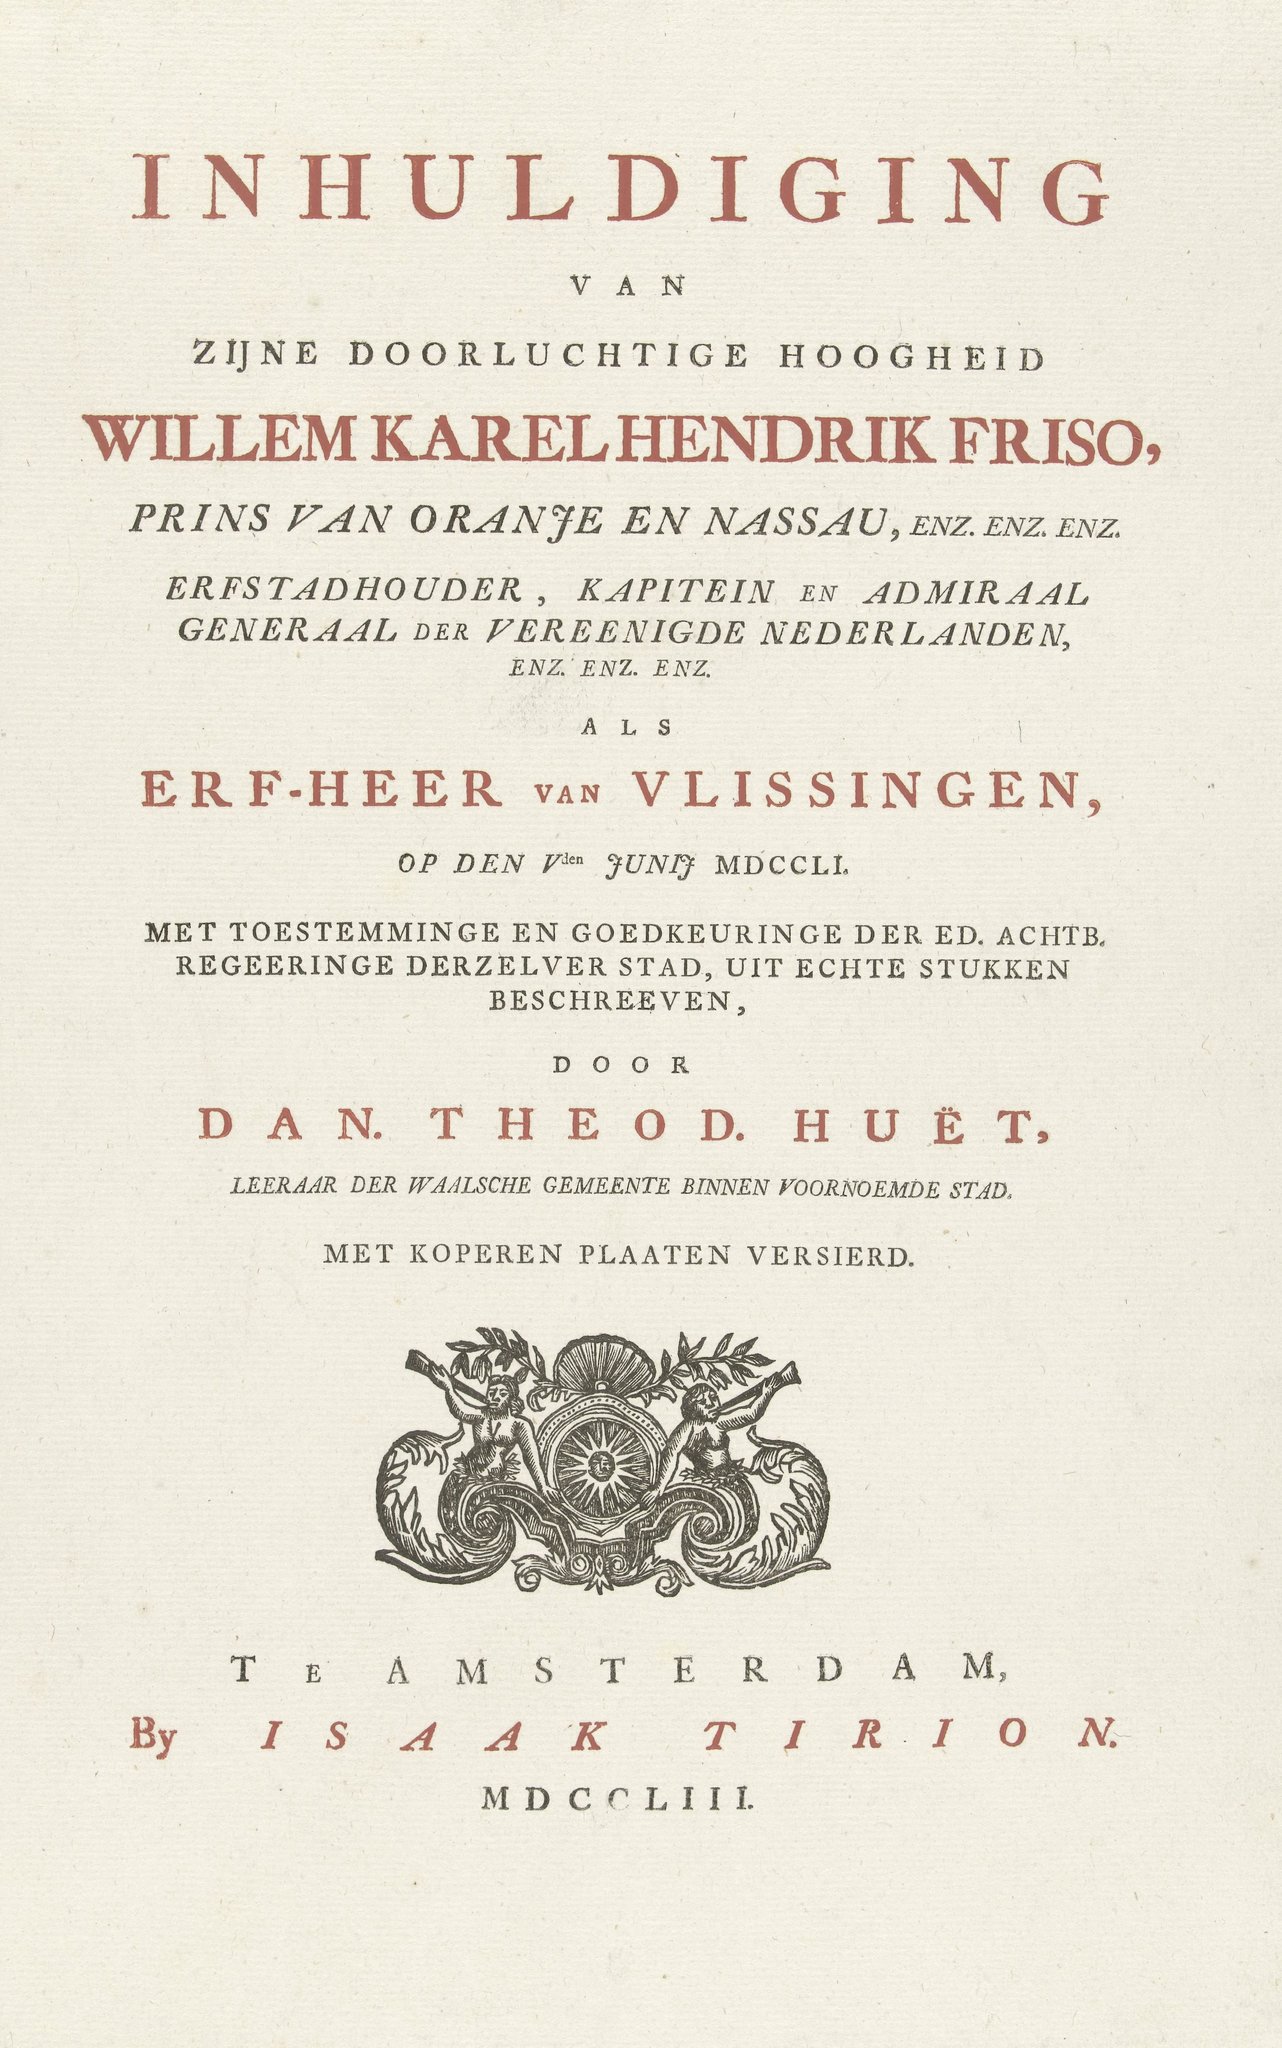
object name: titelblad, titelpagina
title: Titelpagina uit: D.T, Huët, Inhuldiging van zijne doorluchtige hoogheid Willem Karel Hendrik Friso (...) als erf-heer van Vlissingen, op den Vden junij MDCCLI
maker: isaak tirion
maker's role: publisher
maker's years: 1705-1765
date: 1753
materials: paper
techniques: letterpress printing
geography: amsterdam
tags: the hague, willem iv (prins van oranje-nassau), title-page, flushing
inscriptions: collector's mark: Lugt 2228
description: Titelpagina afkomstig uit: D.T, Huët, Inhuldiging van zijne doorluchtige hoogheid Willem Karel Hendrik Friso ... als erf-heer van Vlissingen, op den Vden junij MDCCLI, Tekst in rood en zwart met onderaan een vignet. Onderdeel van de illustraties van de inhuldiging van Willem IV als erfheer van Vlissingen op 5 juni 1751.